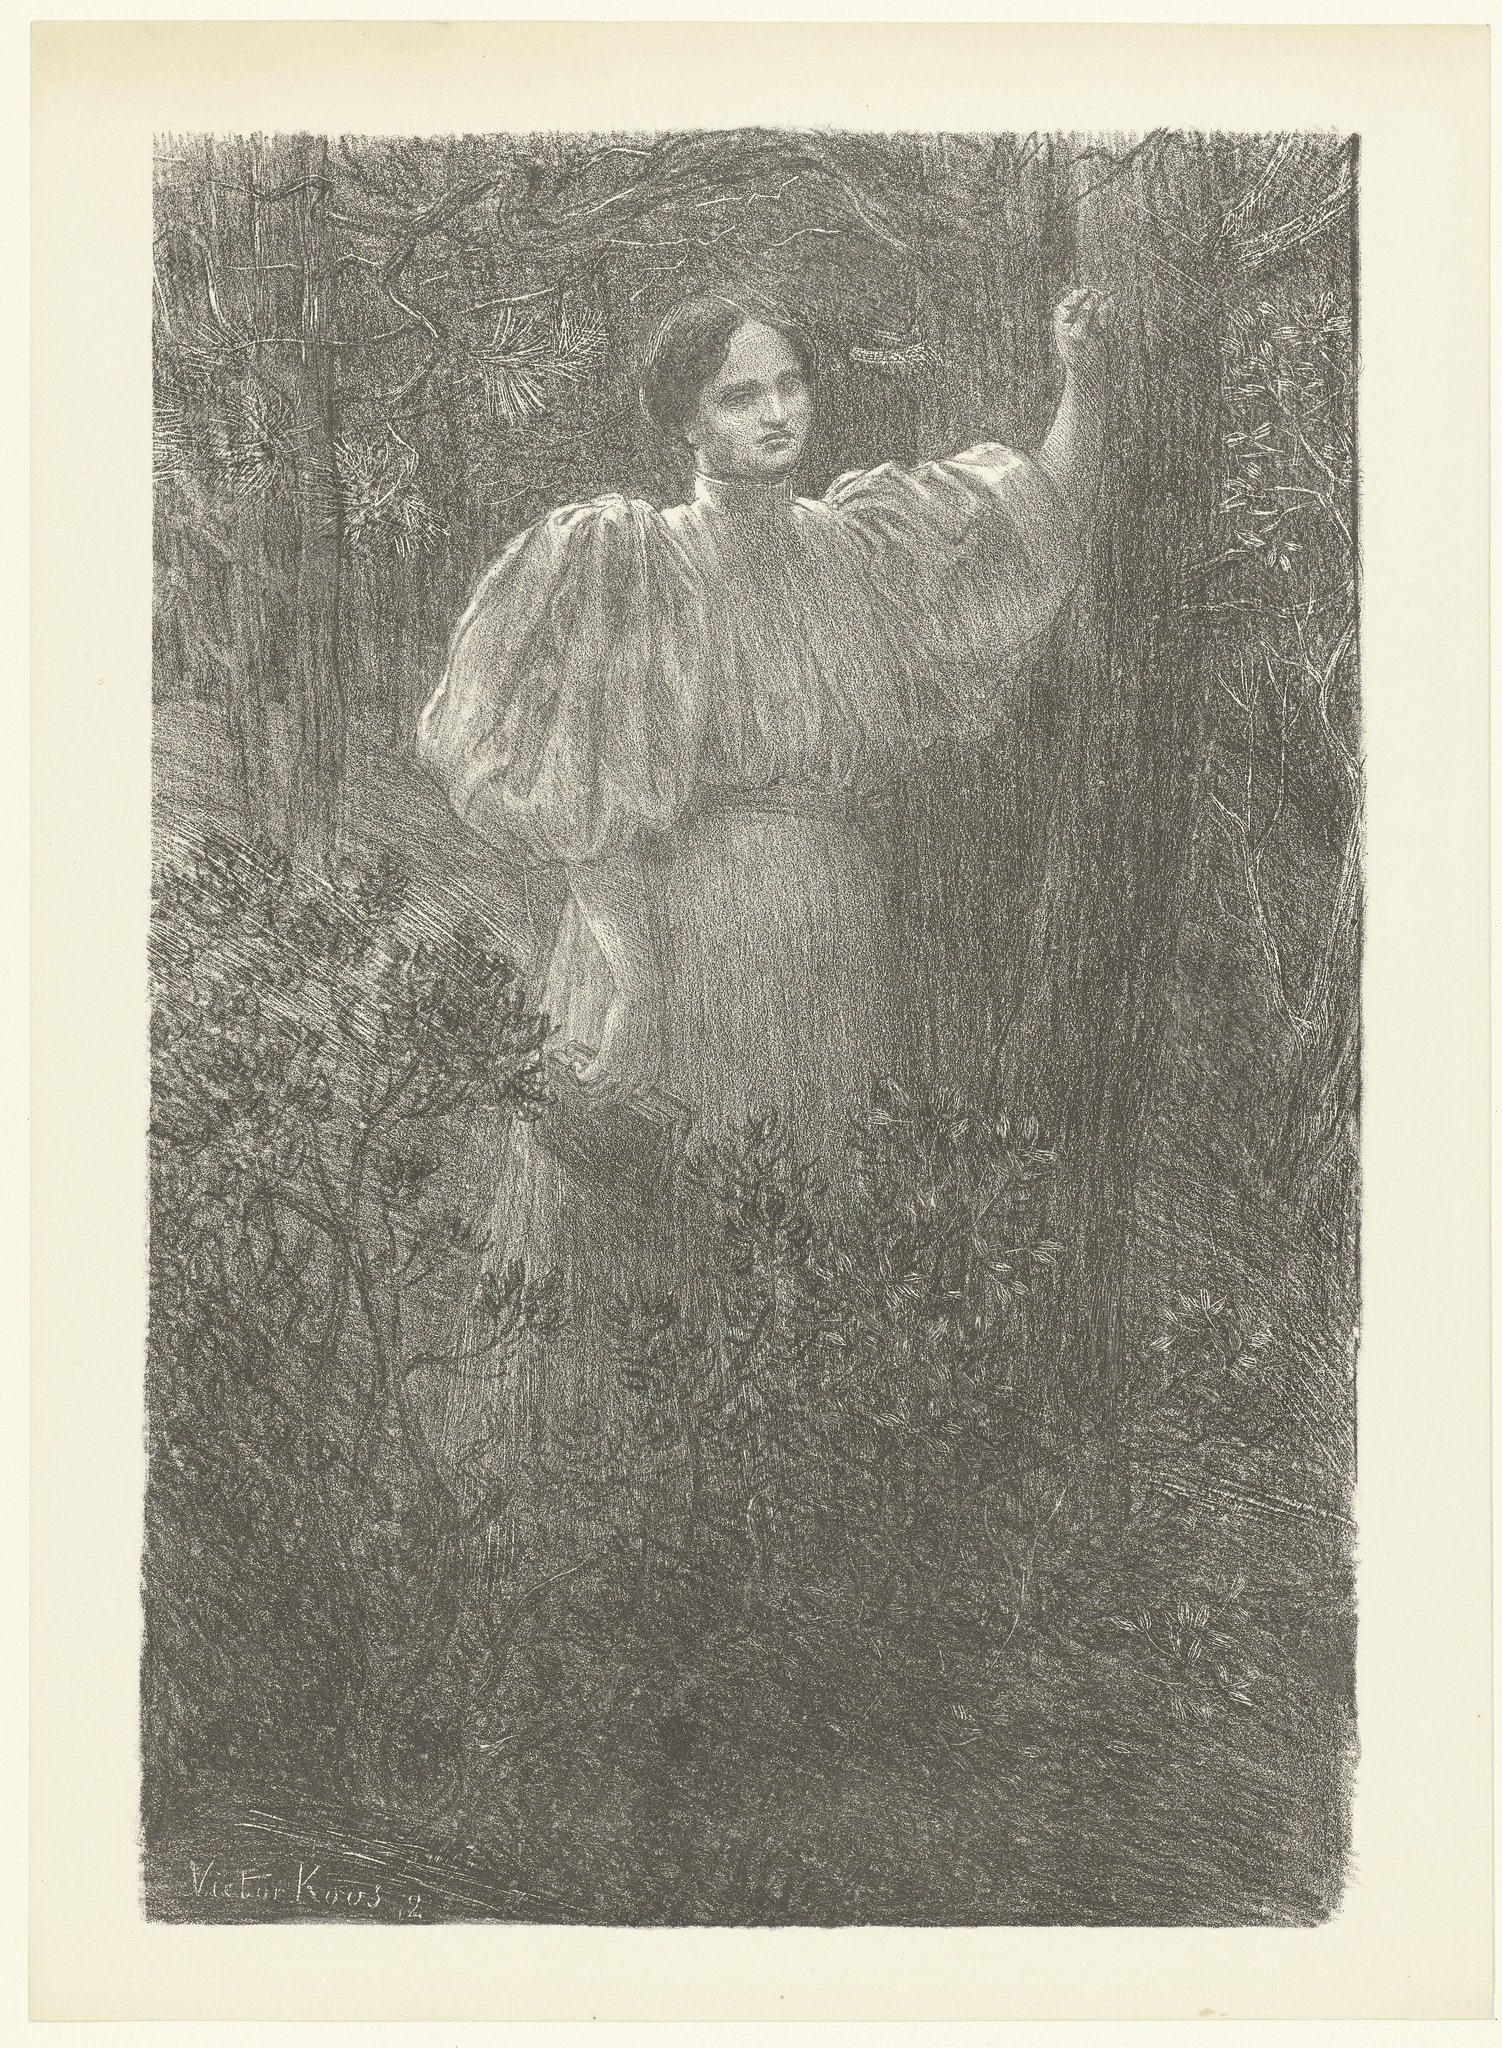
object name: print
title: Eenzaamheid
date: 1892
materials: paper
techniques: lithograph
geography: paris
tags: female sex; woman, forest, wood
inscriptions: collector's mark: Lugt 2228, collector's mark: Lugt 2760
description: Verschenen in album met tien originele prenten als supplement bij tijdschrift: L'Epreuve, editie nr. 12, 1895, prent nr. 4